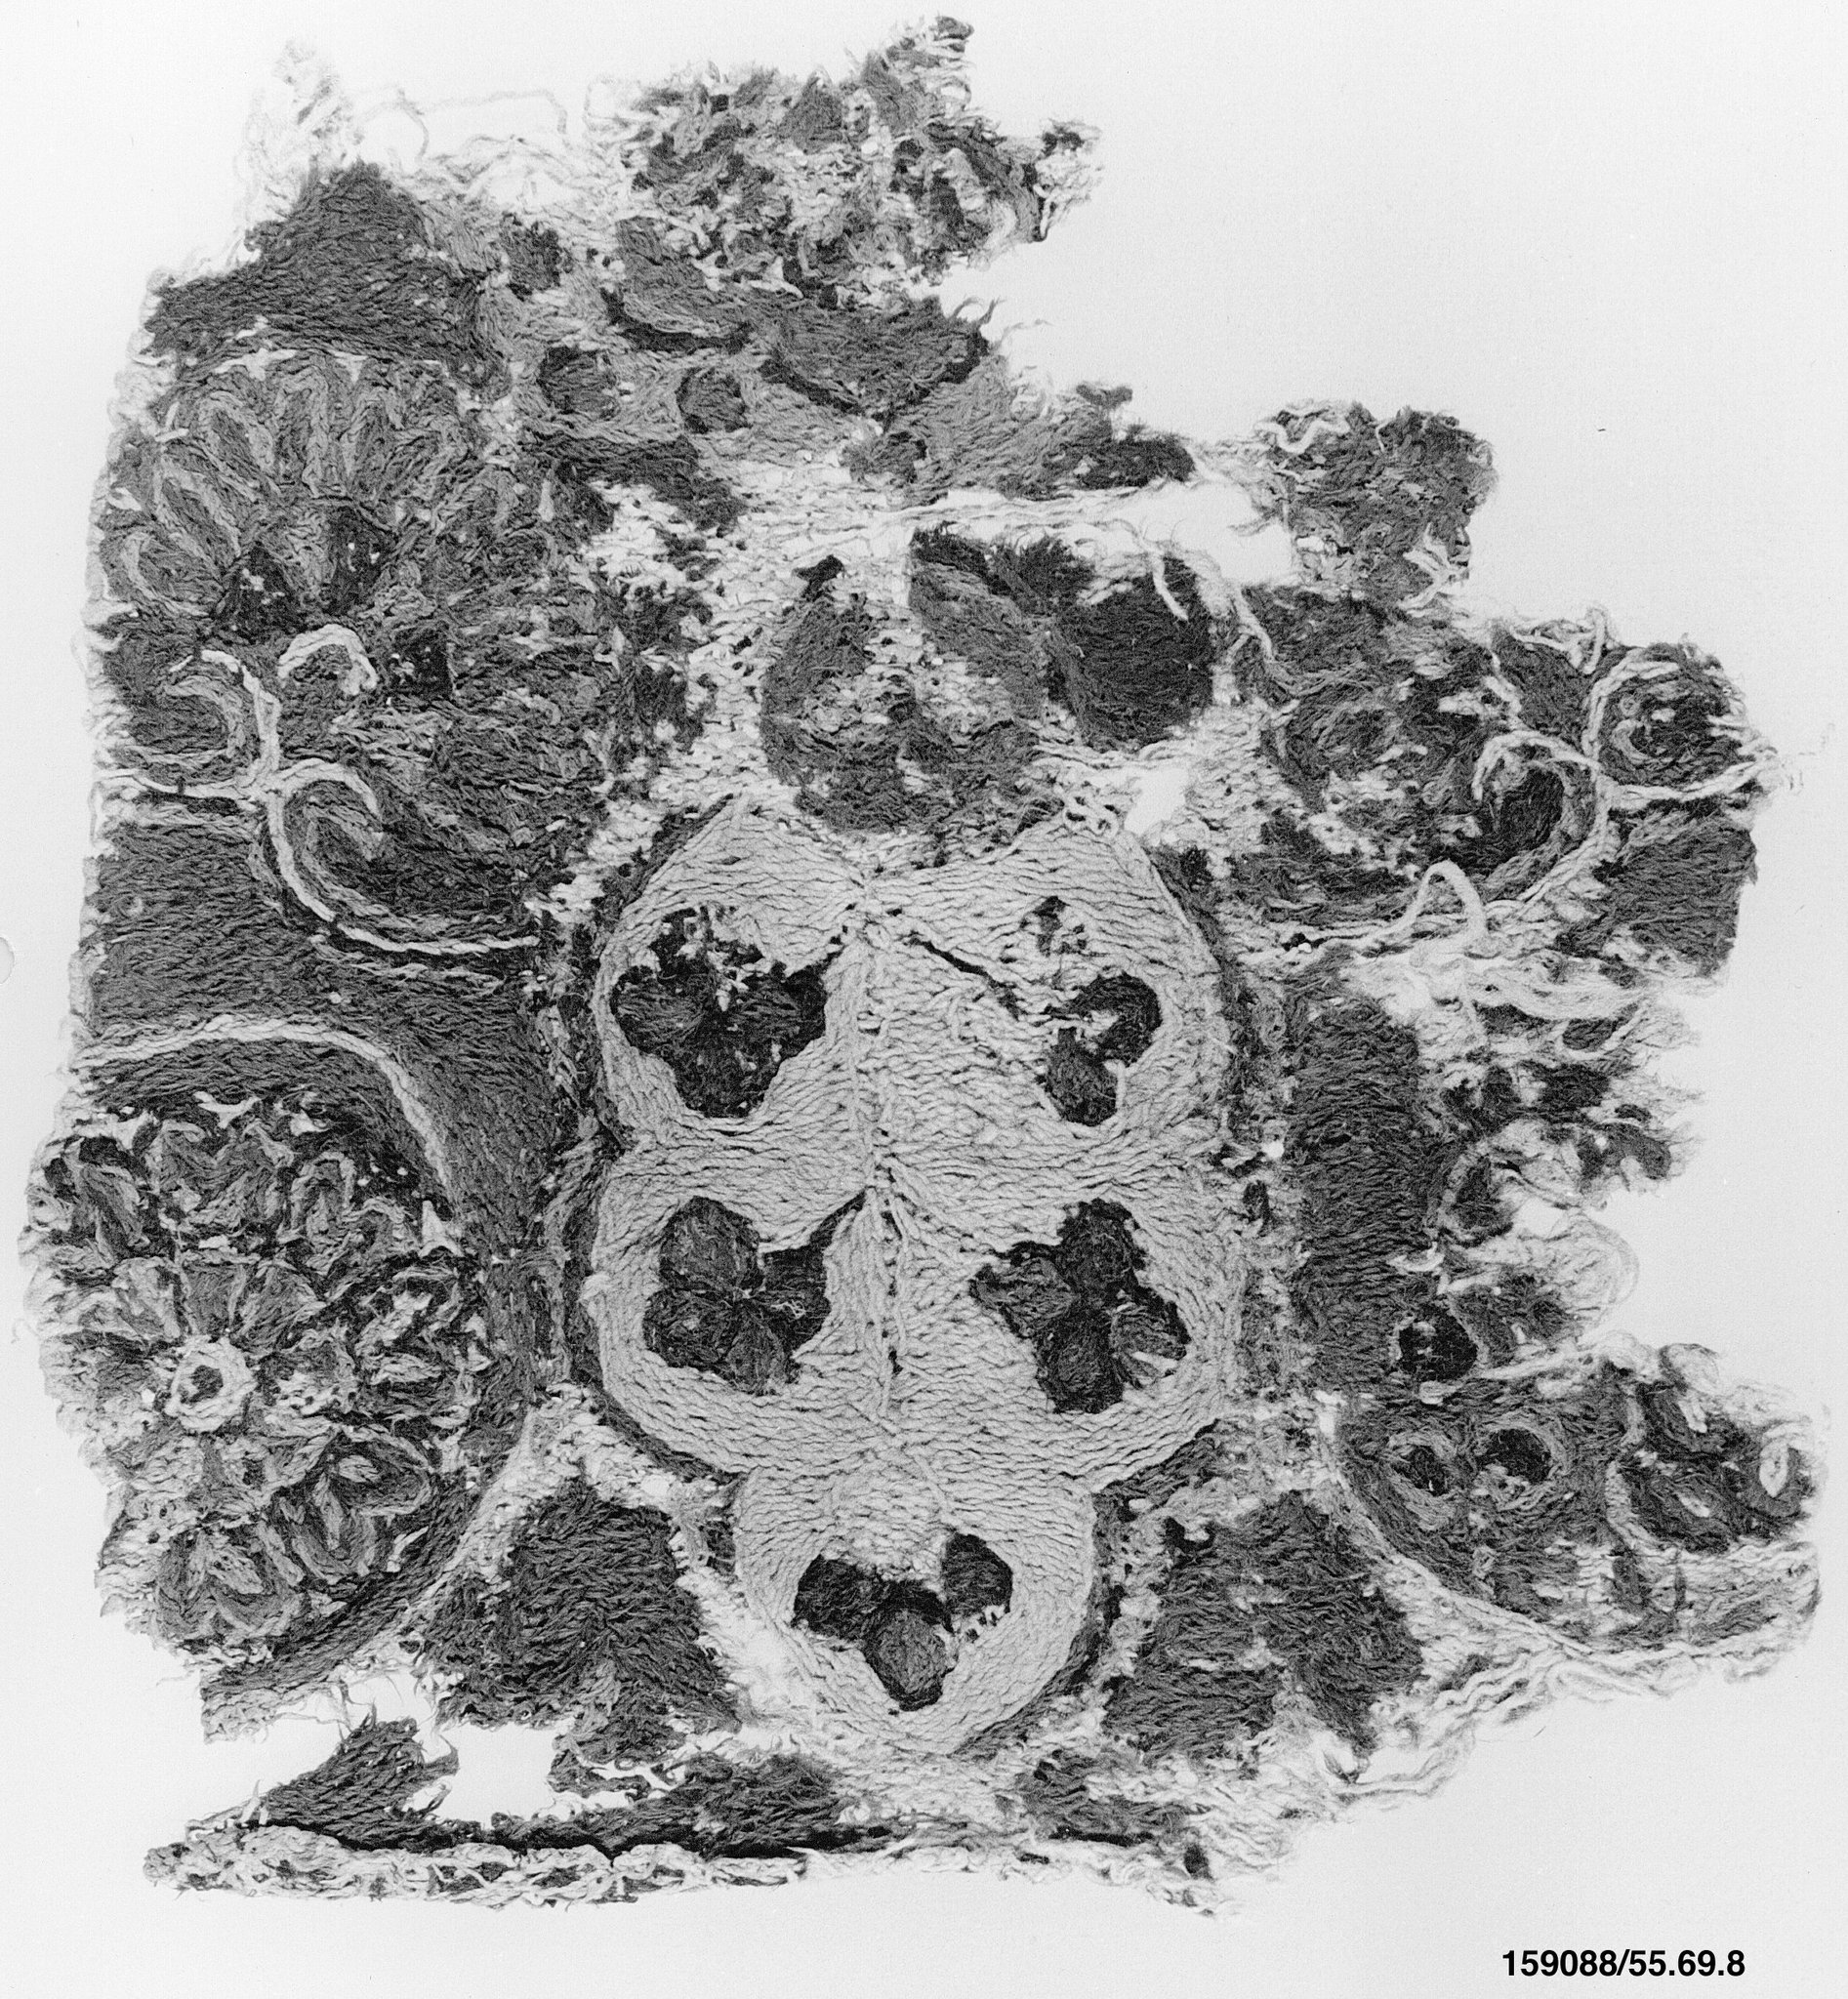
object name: textile fragment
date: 701-900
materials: wool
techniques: embroidery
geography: egypt